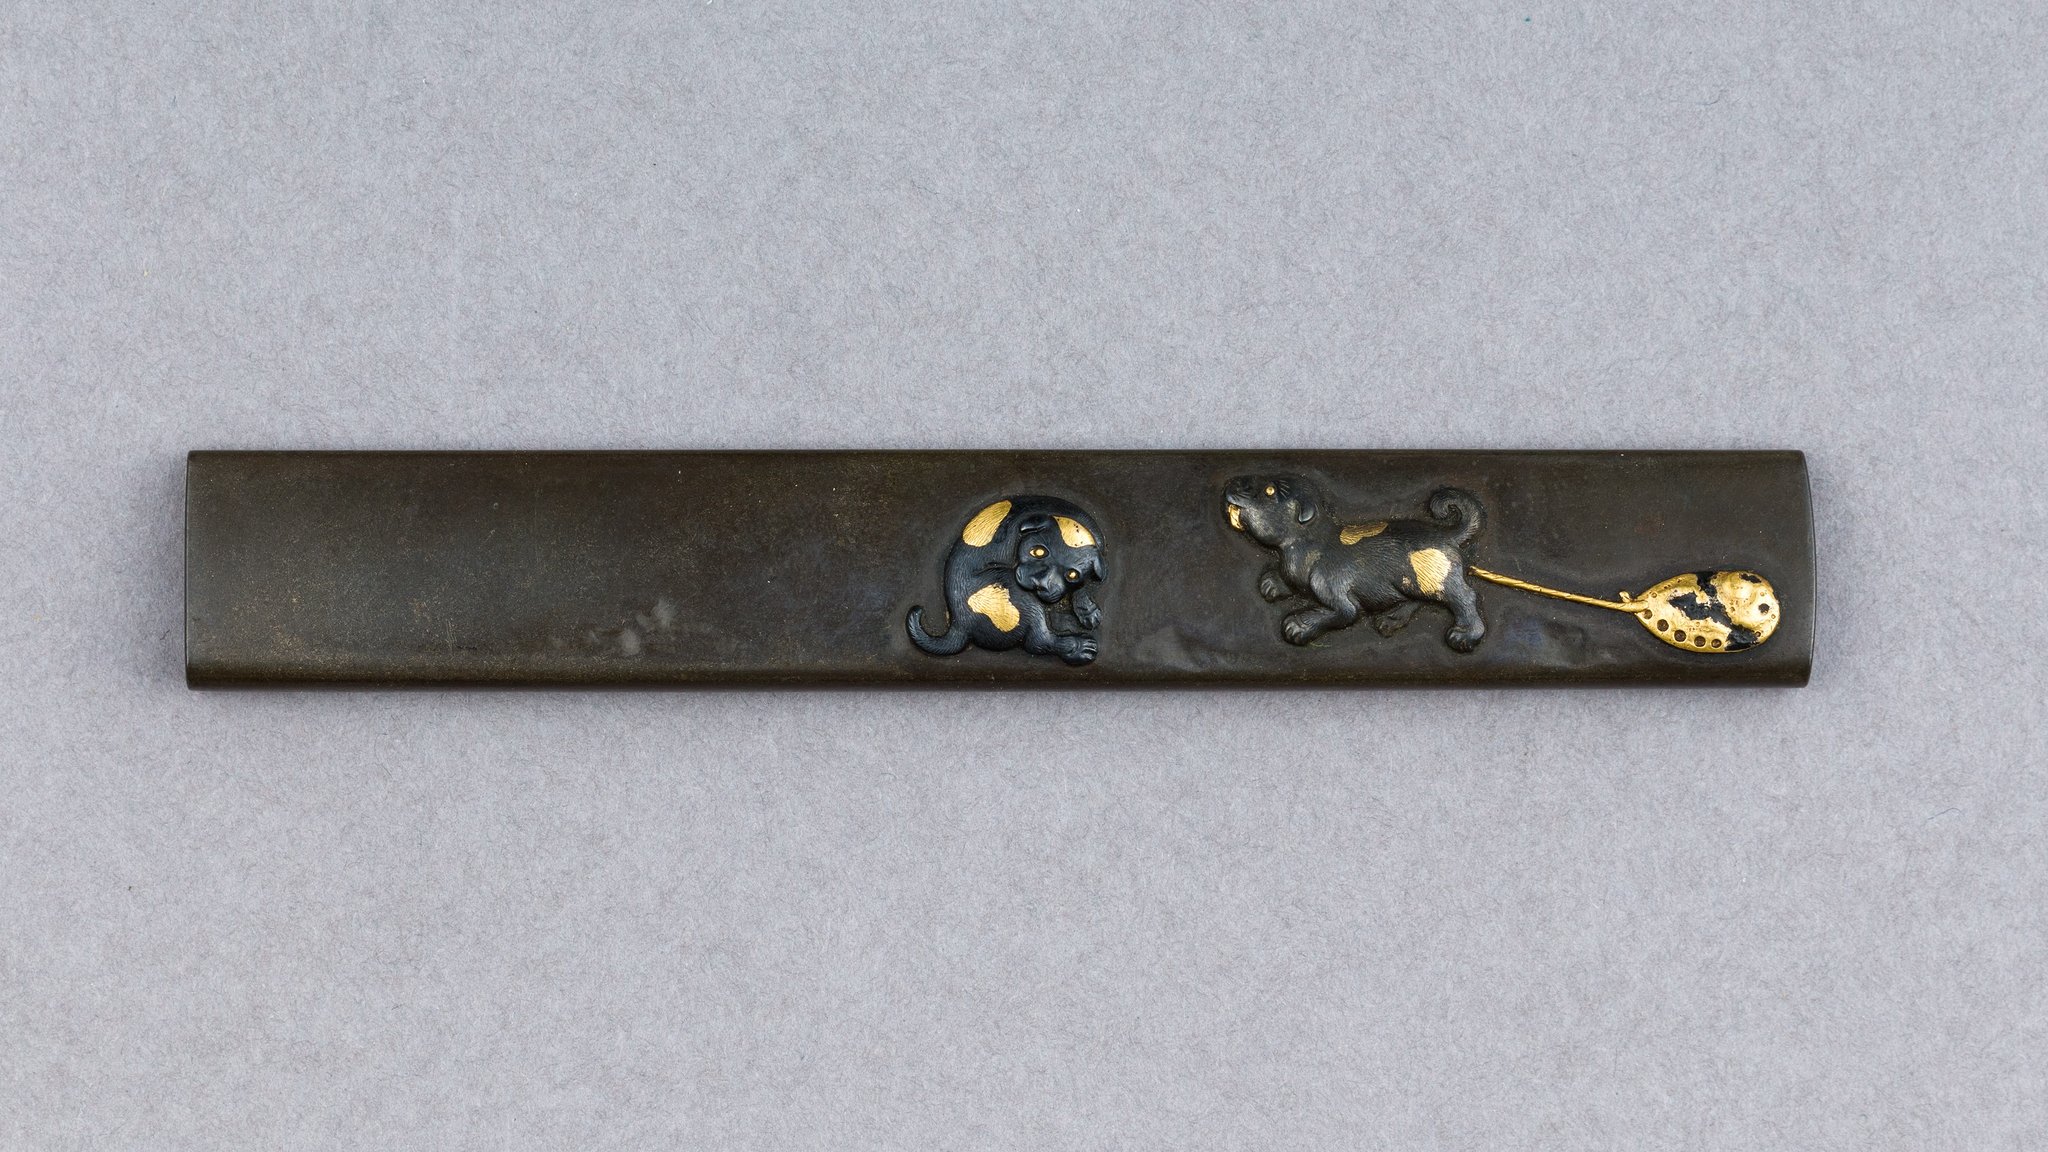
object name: knife handle kozuka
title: Knife Handle (Kozuka)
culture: japanese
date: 1615-1868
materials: gold alloy, silver alloy, gold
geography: japan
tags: dogs